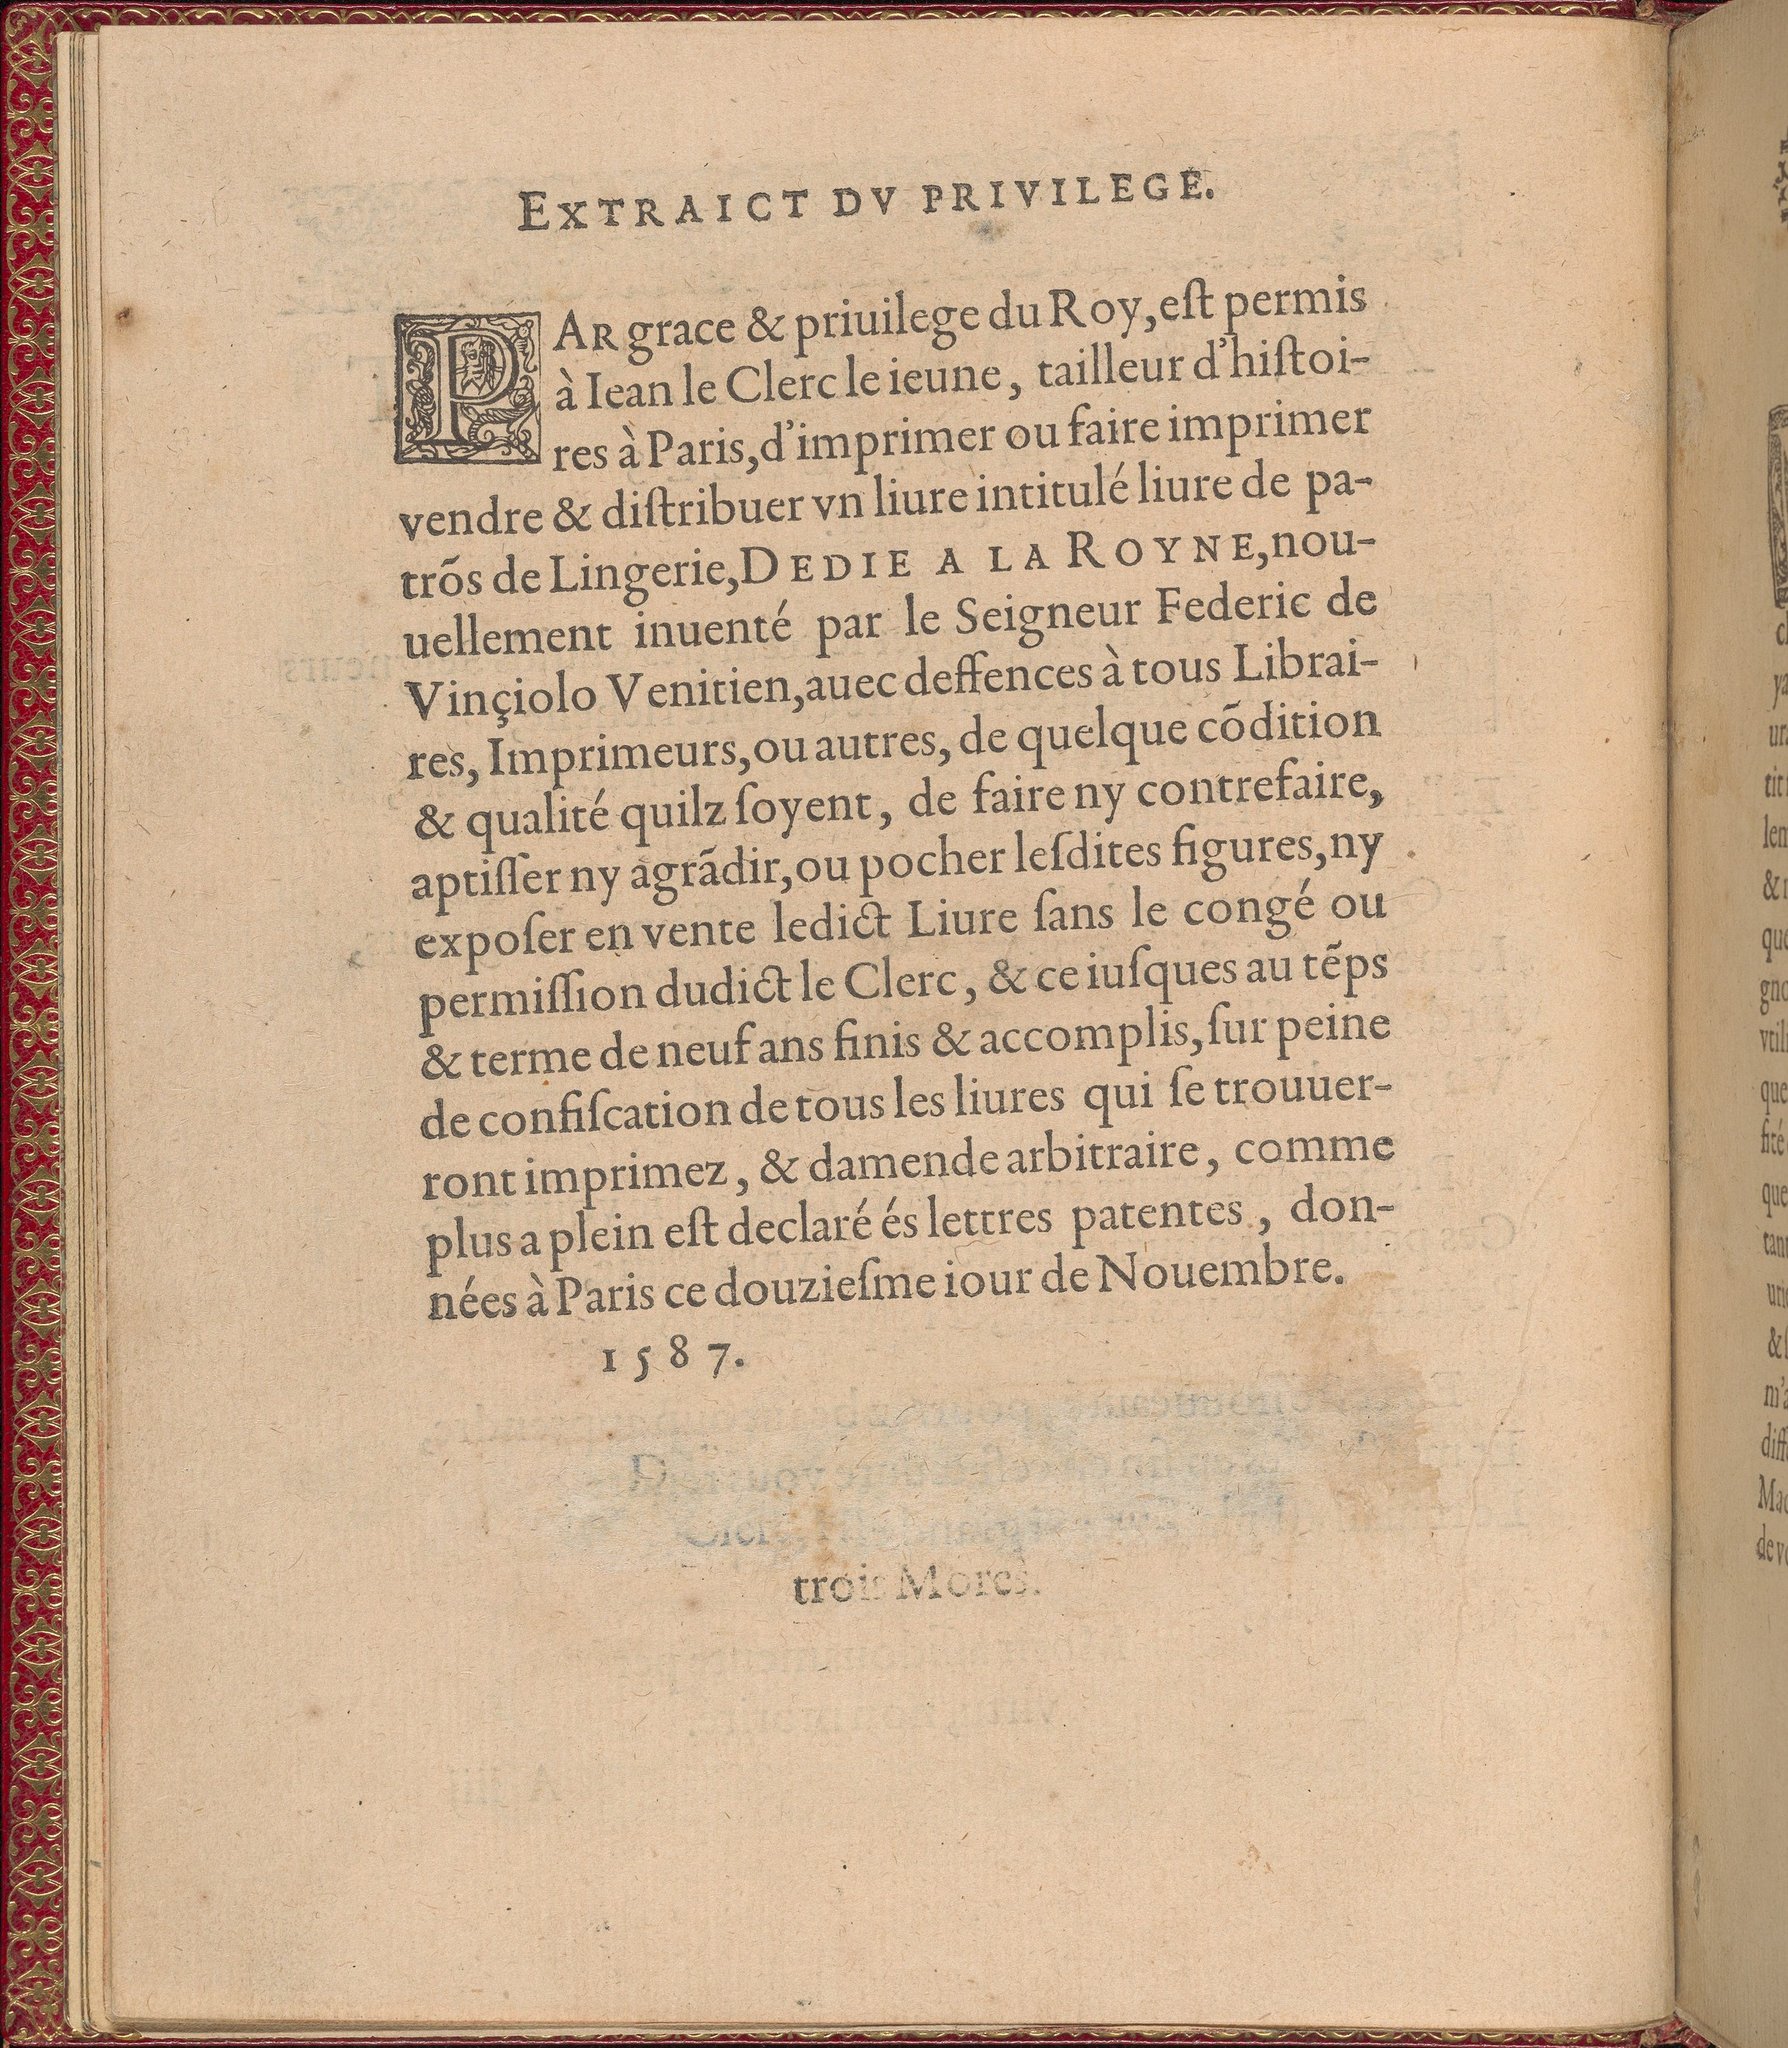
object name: book print ornament architecture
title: Les Singuliers et Nouveaux Portraicts... page 3 (verso)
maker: federico de vinciolo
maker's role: designer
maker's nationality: italian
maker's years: 1582-1599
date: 1588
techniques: woodcut